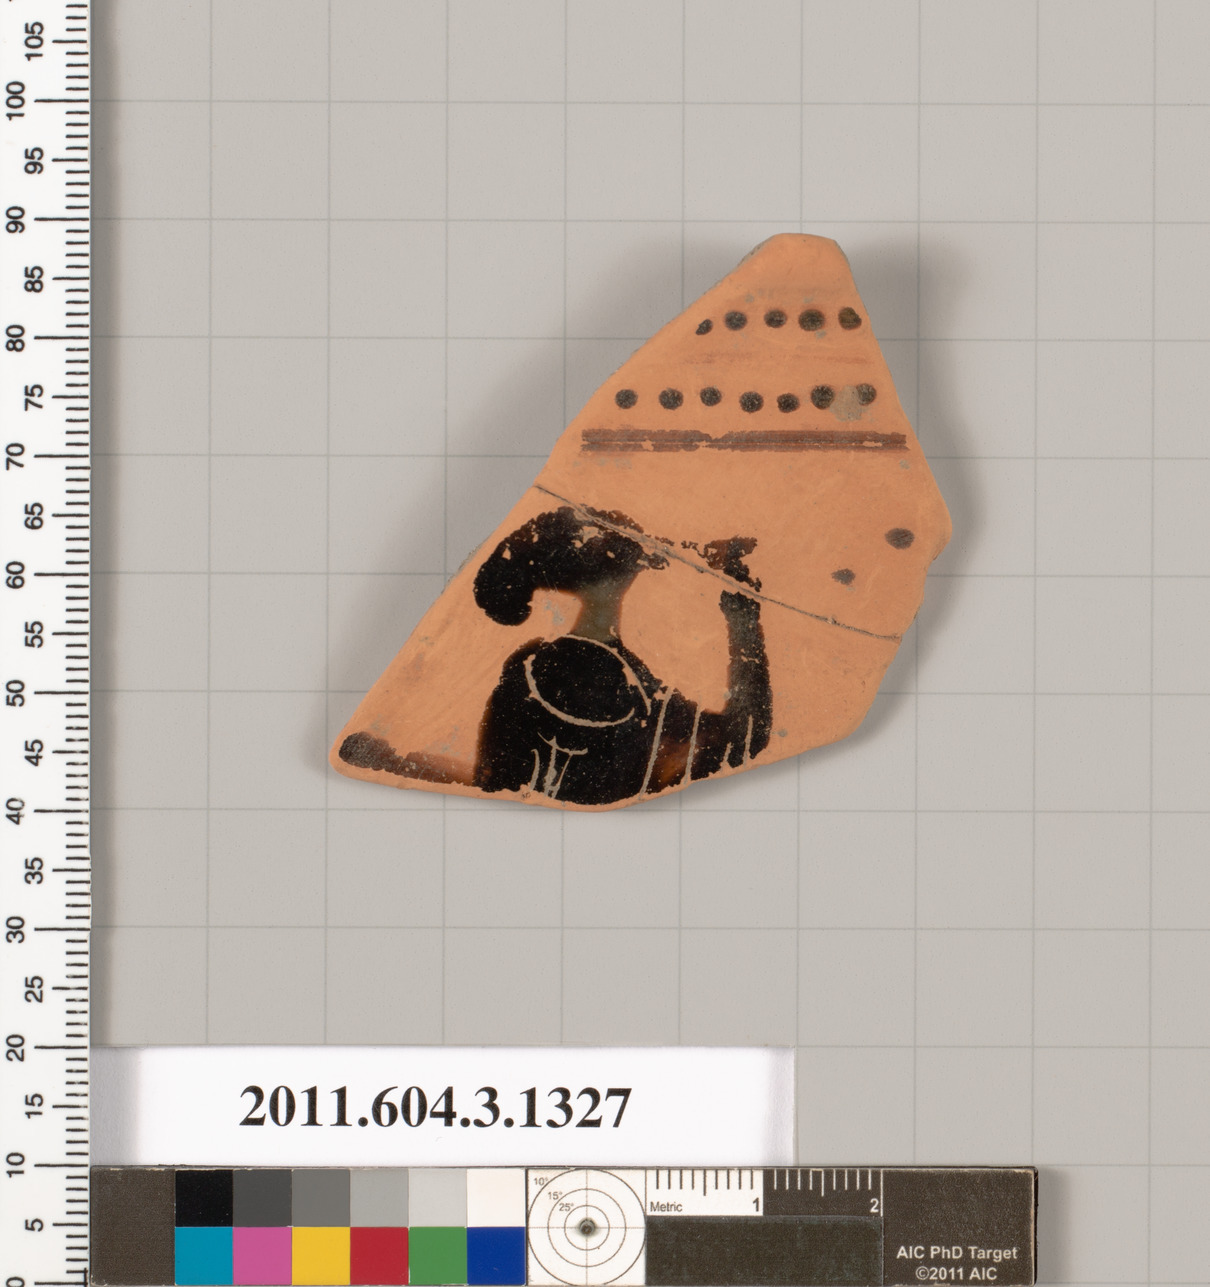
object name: skyphos fragment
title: Terracotta fragment of a skyphos (deep drinking cup)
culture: greek, attic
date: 534-468 BCE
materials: terracotta